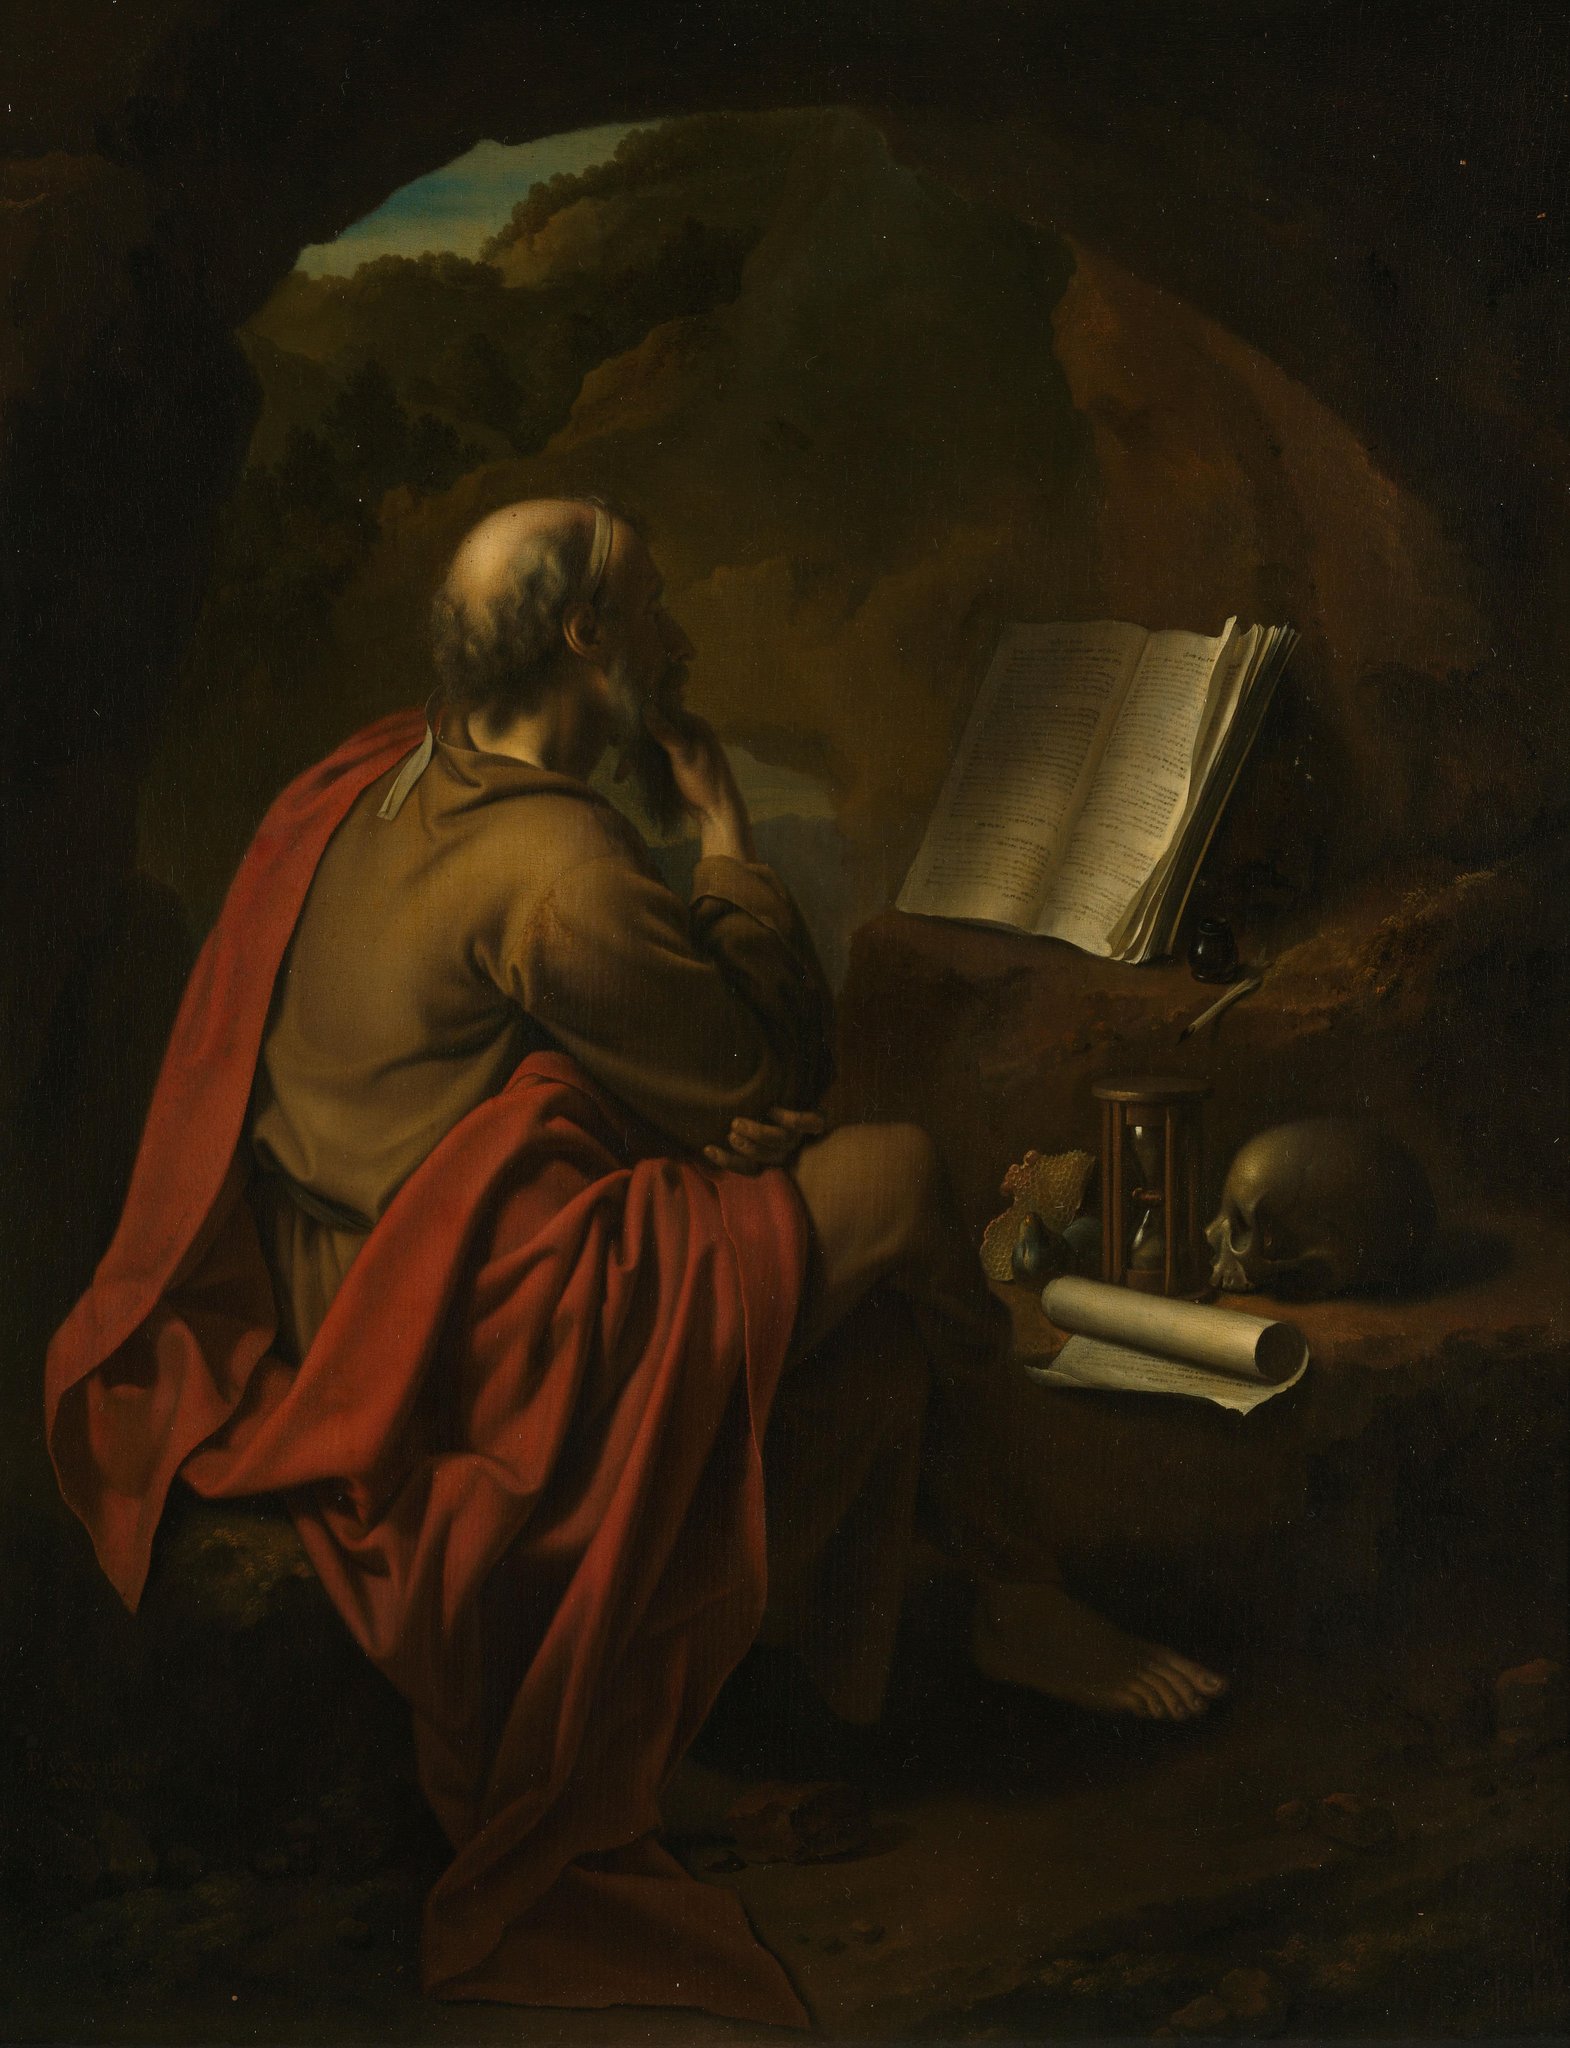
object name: painting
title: St Jerome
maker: pieter van der werff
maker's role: draughtsman, painter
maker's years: 1665-1722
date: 1710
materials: oil, panel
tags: st. jerome as hermit in a landscape, reading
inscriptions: signature and date: ‘P. vr Werff fe Anno 1710’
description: De heilige Hieronymus zittend in een grot, lezend in een boek. Voor hem op een rots liggen een zandloper, een schedel en een opgerolde blad papier.